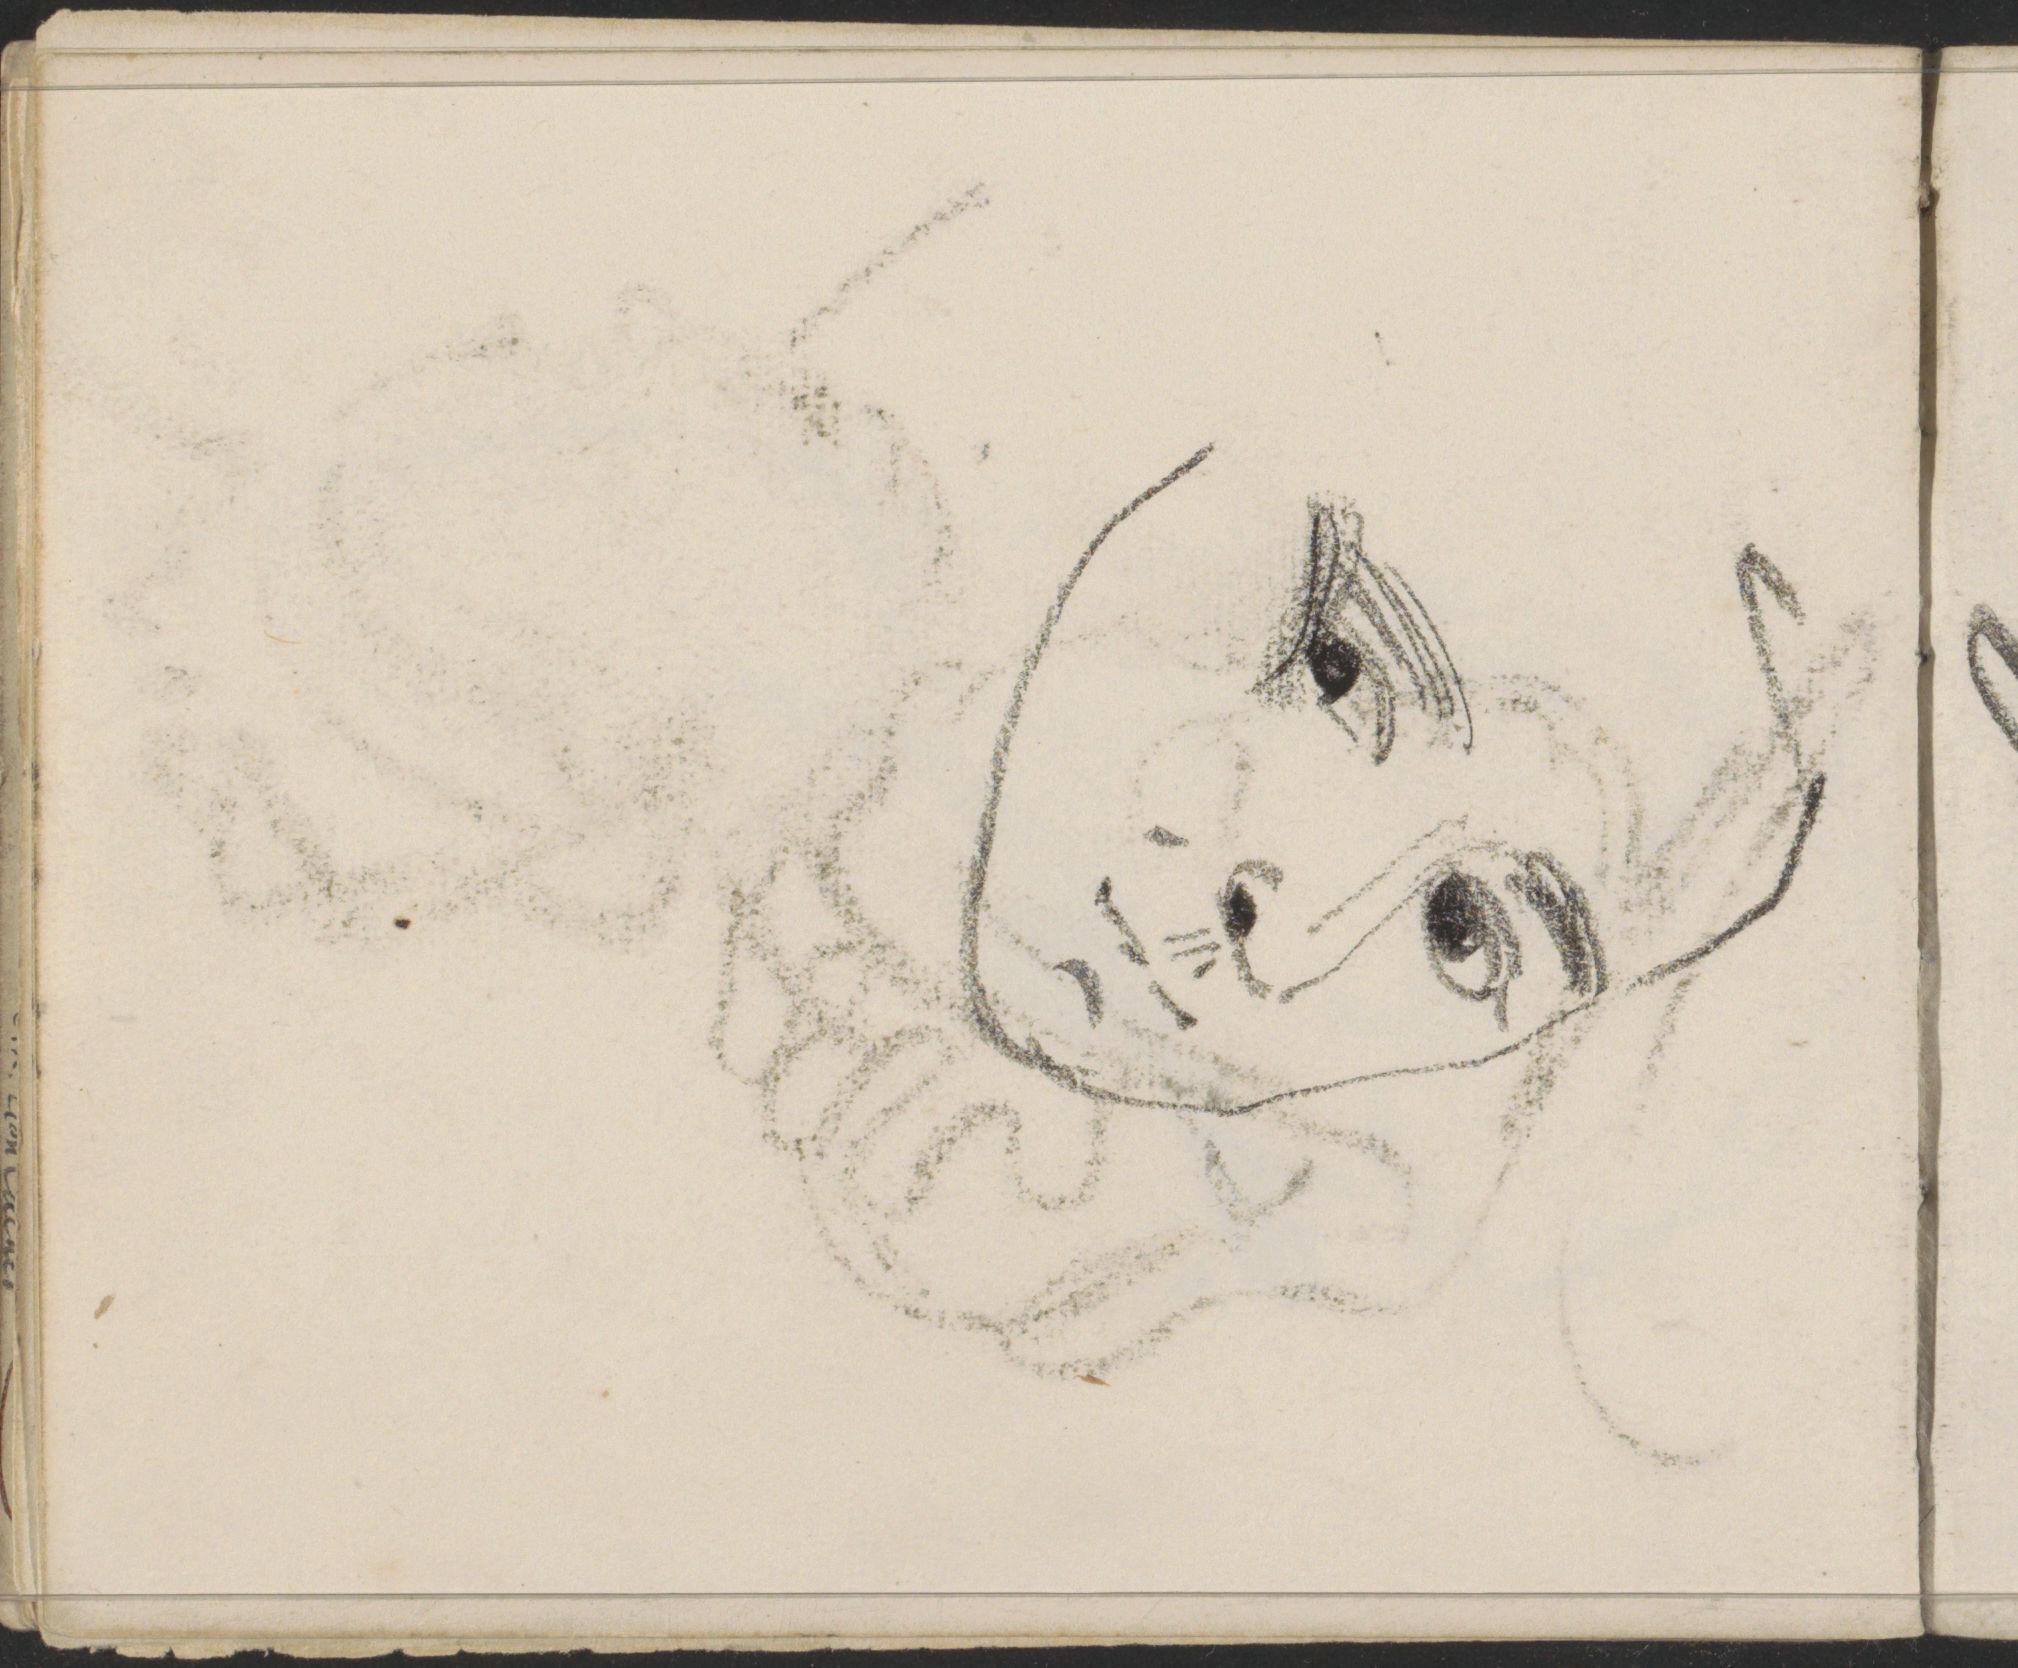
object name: sketchbook leaf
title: Kop van een jongen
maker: carel adolph lion cachet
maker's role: draughtsman, print maker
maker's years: 1864-1945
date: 1895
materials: chalk, paper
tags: head (human)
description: Blad 9 verso uit een schetsboek met 11 bladen.